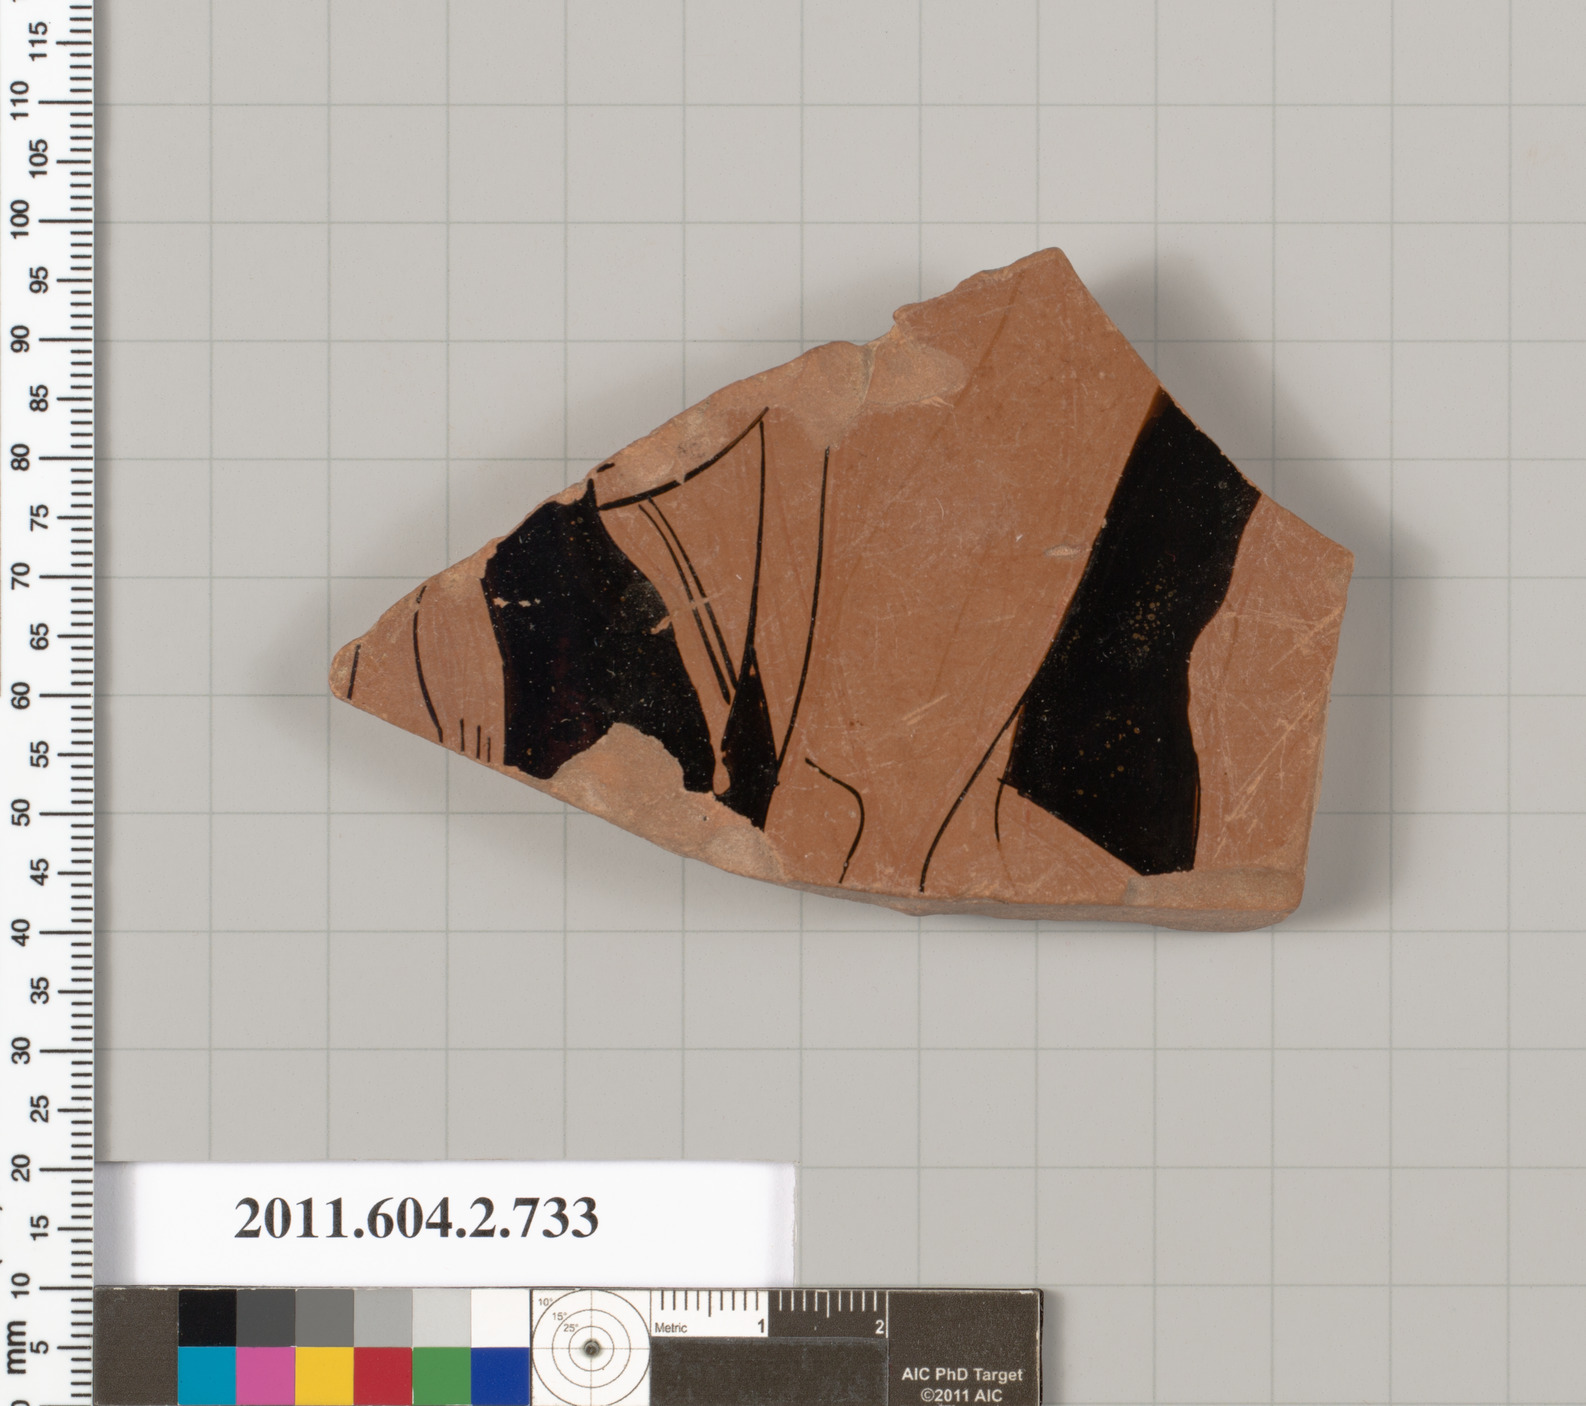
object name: calyx krater fragment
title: Terracotta fragment of a calyx-krater (bowl for mixing wine and water)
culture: greek, attic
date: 470-460 BCE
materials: terracotta